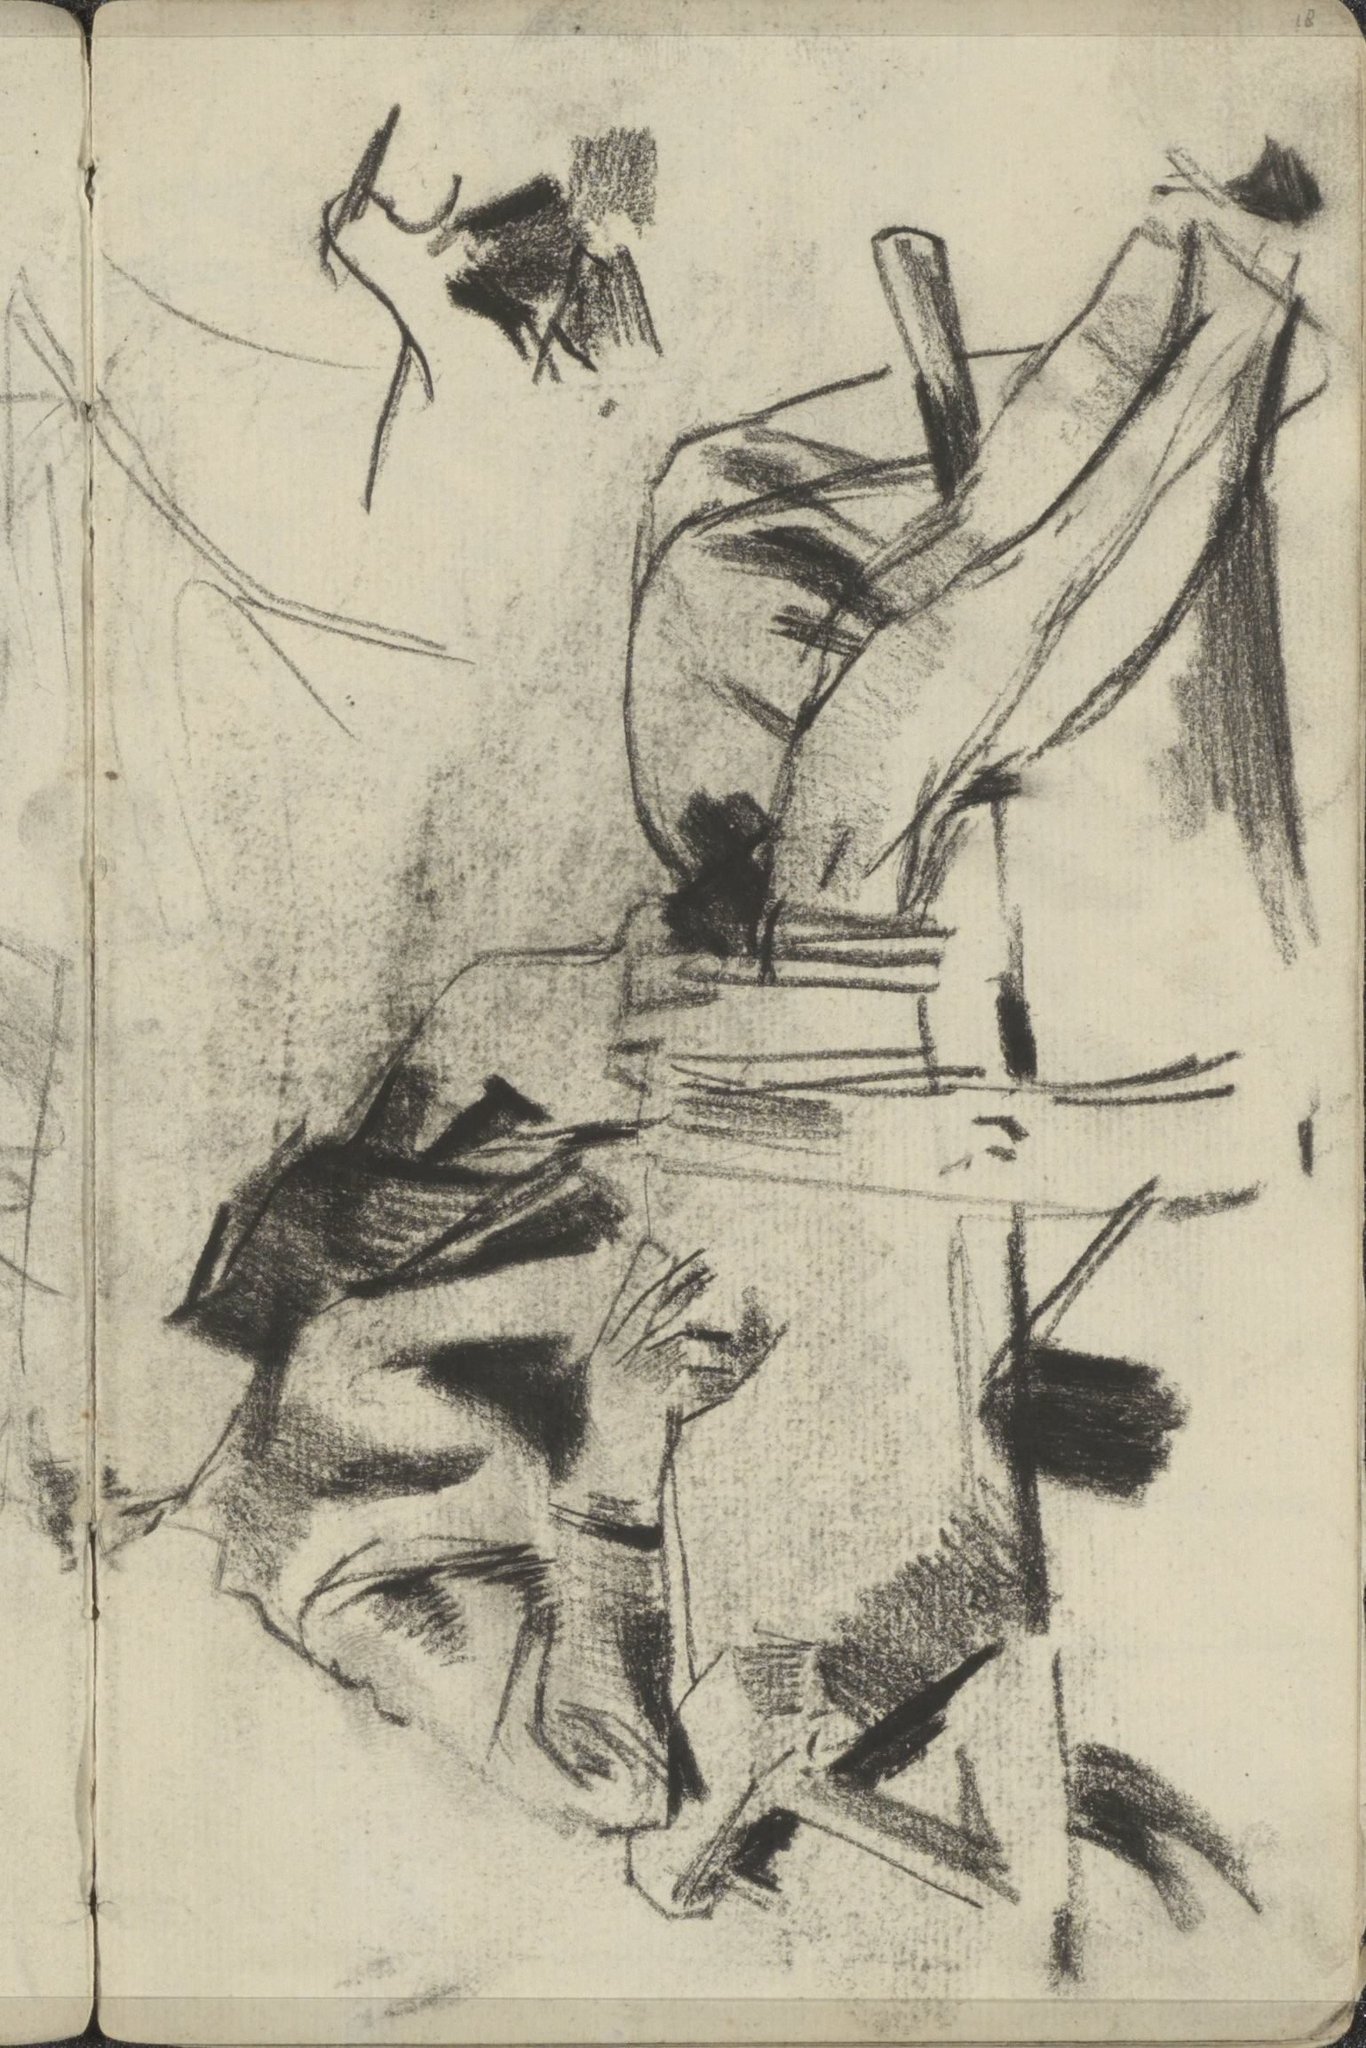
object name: sketchbook leaf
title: Man in een kruiwagen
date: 1883-1885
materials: chalk, paper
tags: adult man, wheelbarrow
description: Pagina 18 uit een schetsboek met 16 bladen.